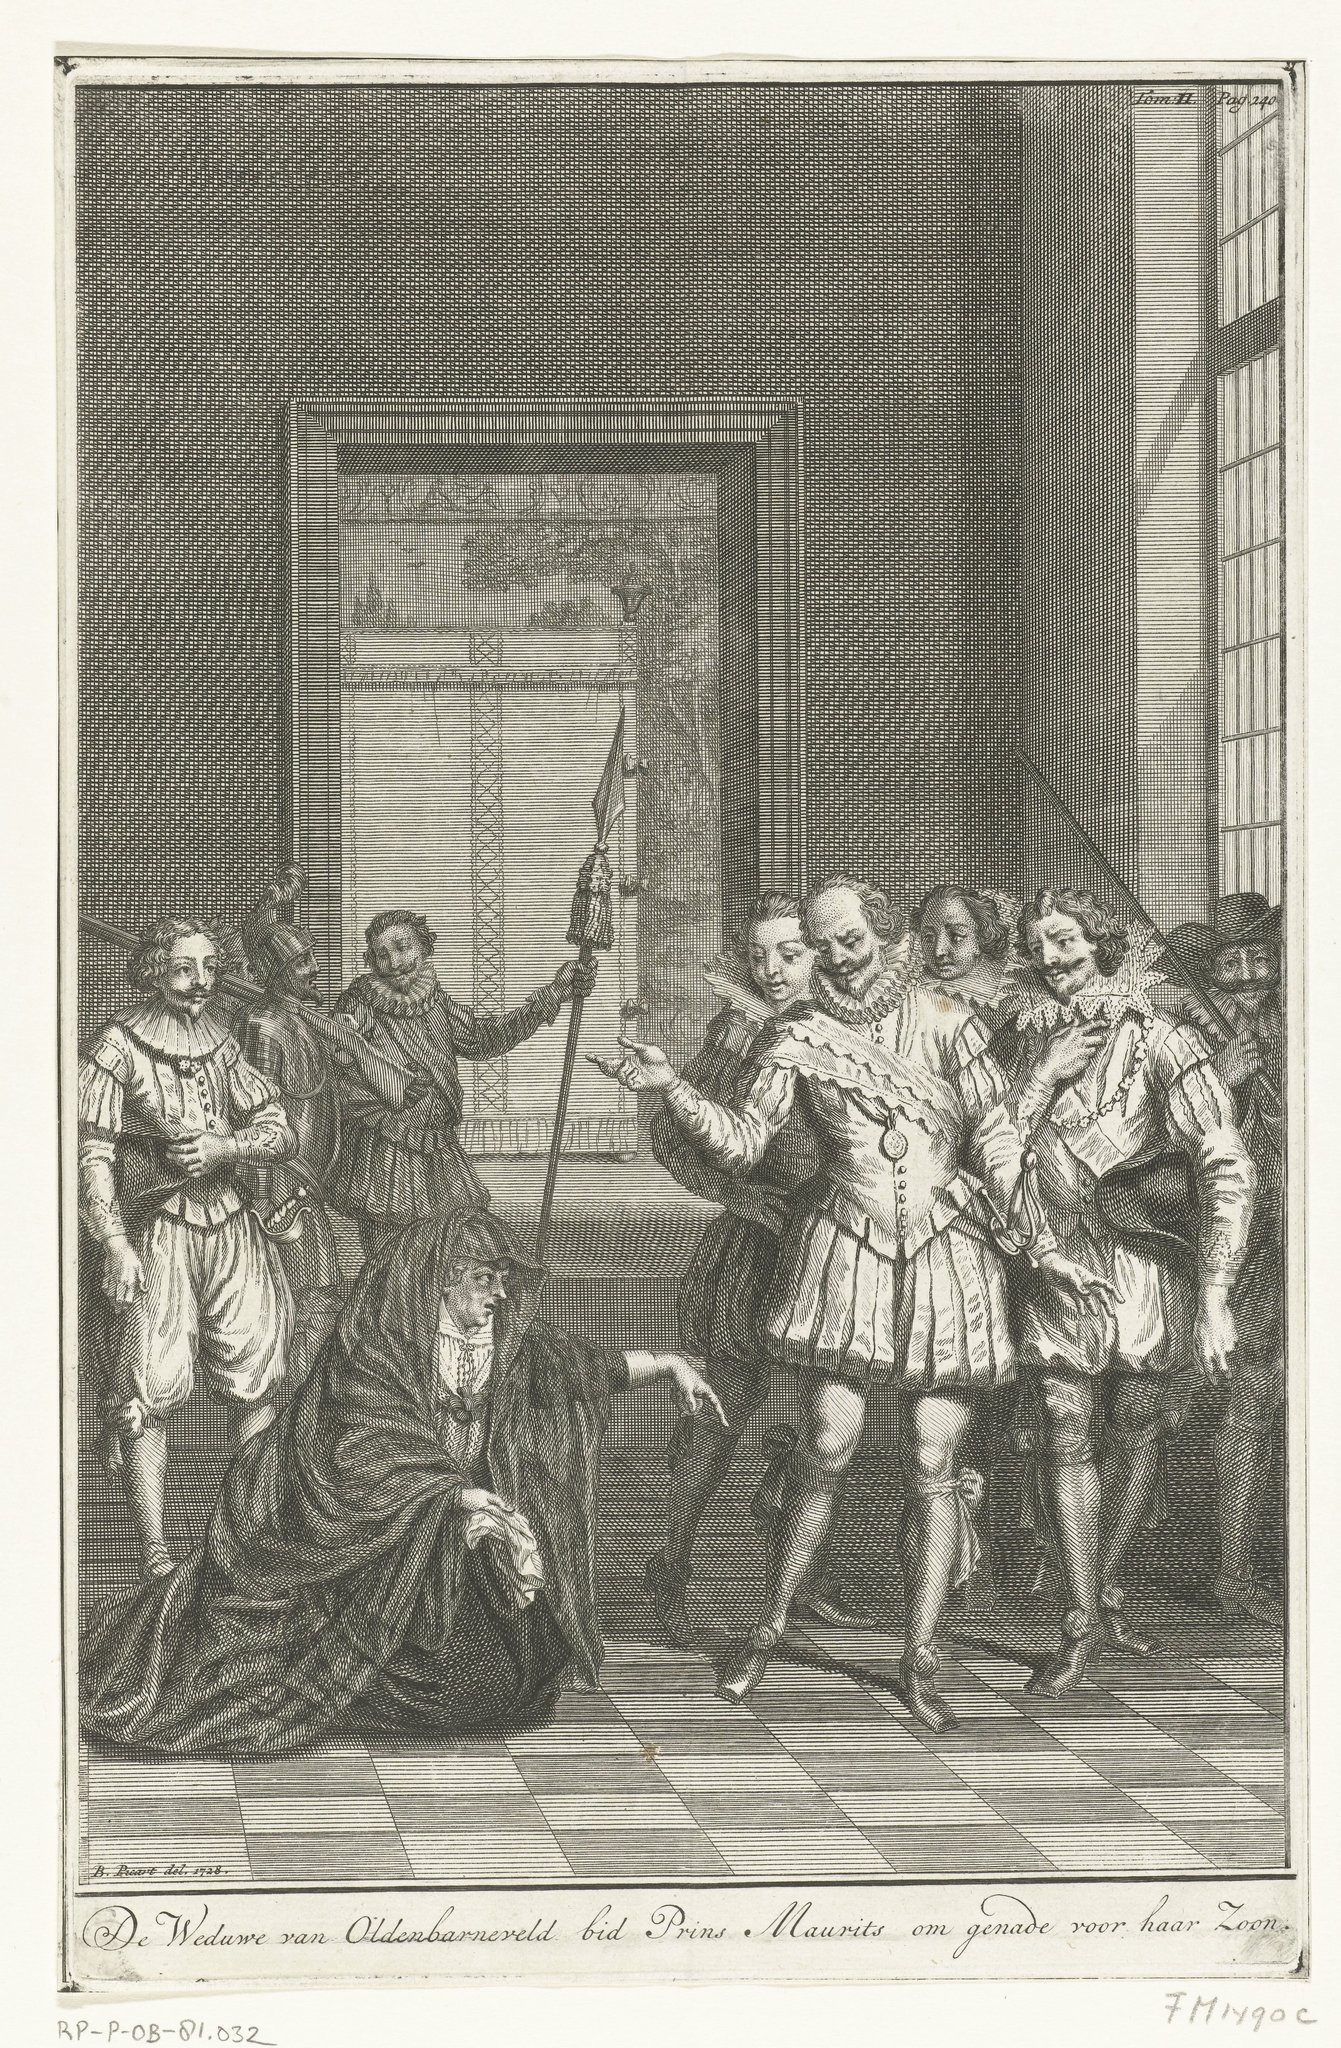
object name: print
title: De Weduwe van Oldenbarneveld bid Prins Maurits om genade voor haar Zoon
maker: bernard picart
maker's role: draughtsman, print maker, publisher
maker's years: 1673-1733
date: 1728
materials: paper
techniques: etching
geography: northern netherlands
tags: the hague, maurice (prince of orange), (revolutionary) plot, conspiracy, granting mercy; free pardon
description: Gebruikt als illustratie in: J. le Clerc, Geschiedenissen der Vereenigde Nederlanden, sedert den aanvang van die Republyk tot op den Vrede van Utrecht in 't jaar 1713 en het Tractaat van Barriere in 't jaar 1715 gesloten, Z. Chatelain, Amsterdam 1730, 3 delen, dl. II, p. 240.